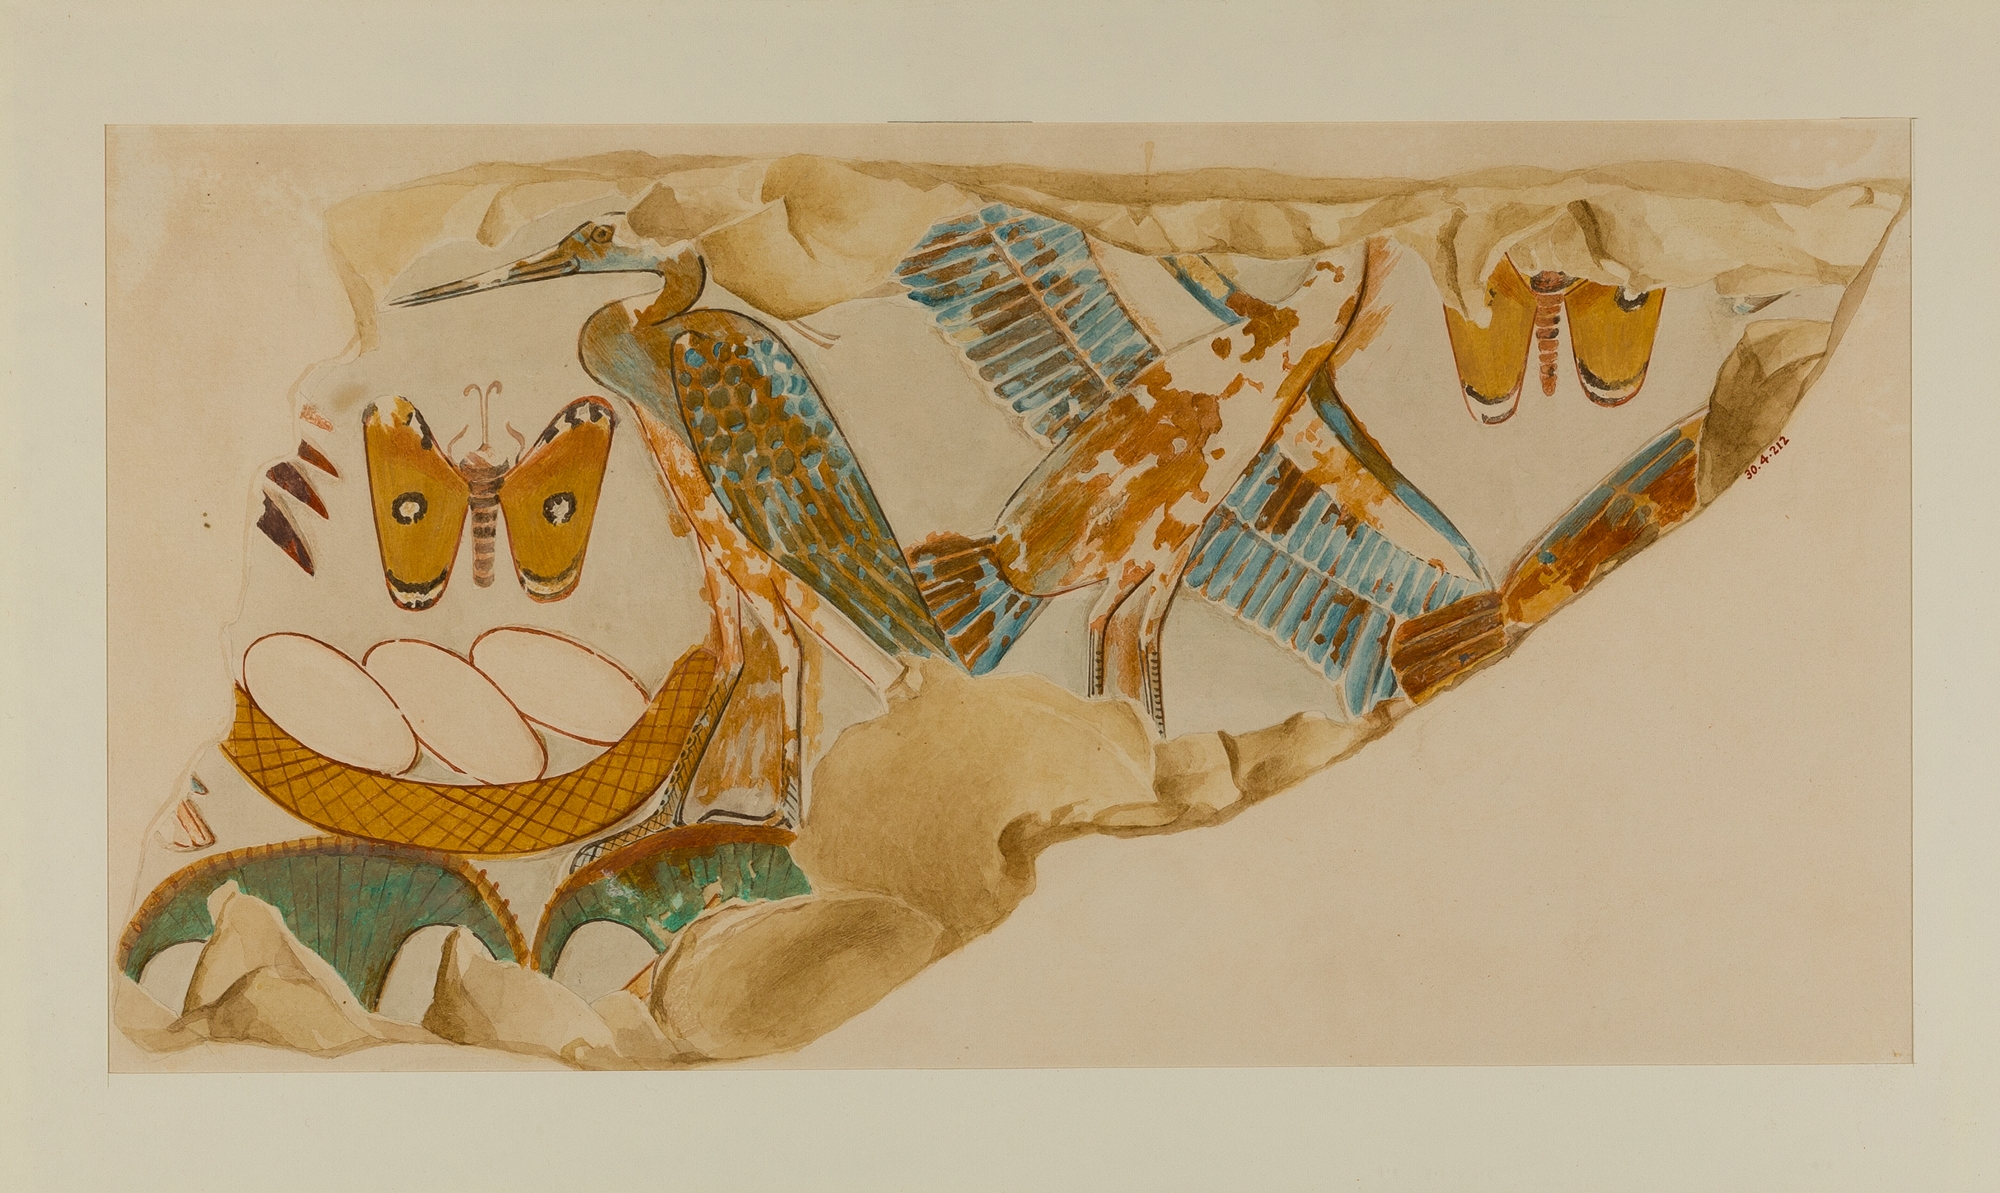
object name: facsimile, puyemre tt 39, nesting bird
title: Nesting Birds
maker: hugh r. hopgood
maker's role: artist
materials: paper, paint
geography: egypt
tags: birds,butterflies